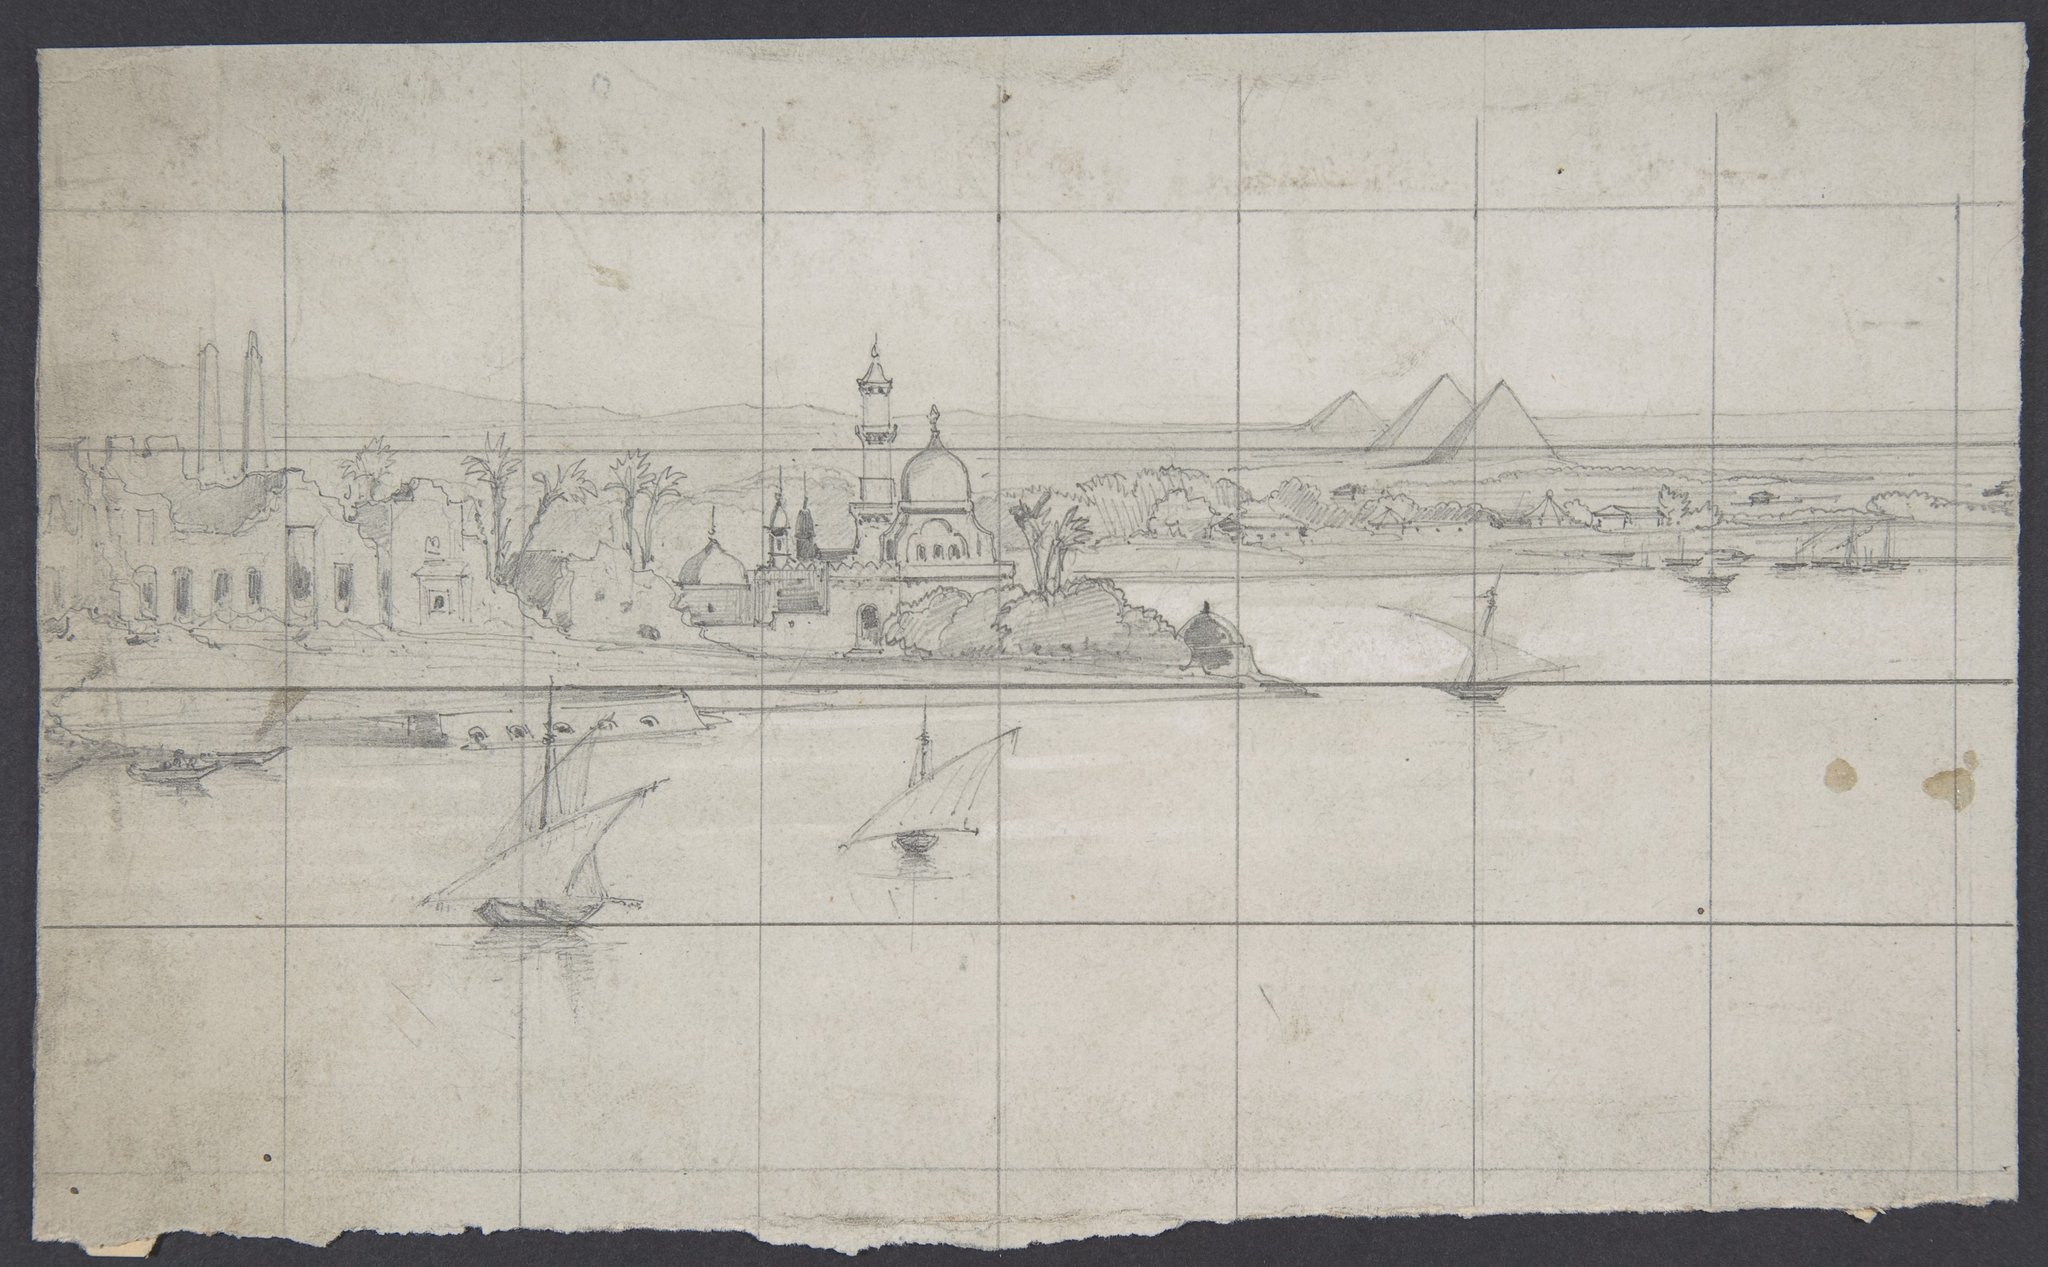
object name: drawing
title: Design for a Stage Set at the Opéra, Paris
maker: eugène cicéri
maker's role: artist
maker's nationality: french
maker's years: 1813-1890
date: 1840-1890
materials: graphite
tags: buildings,pyramids,boats,stage design